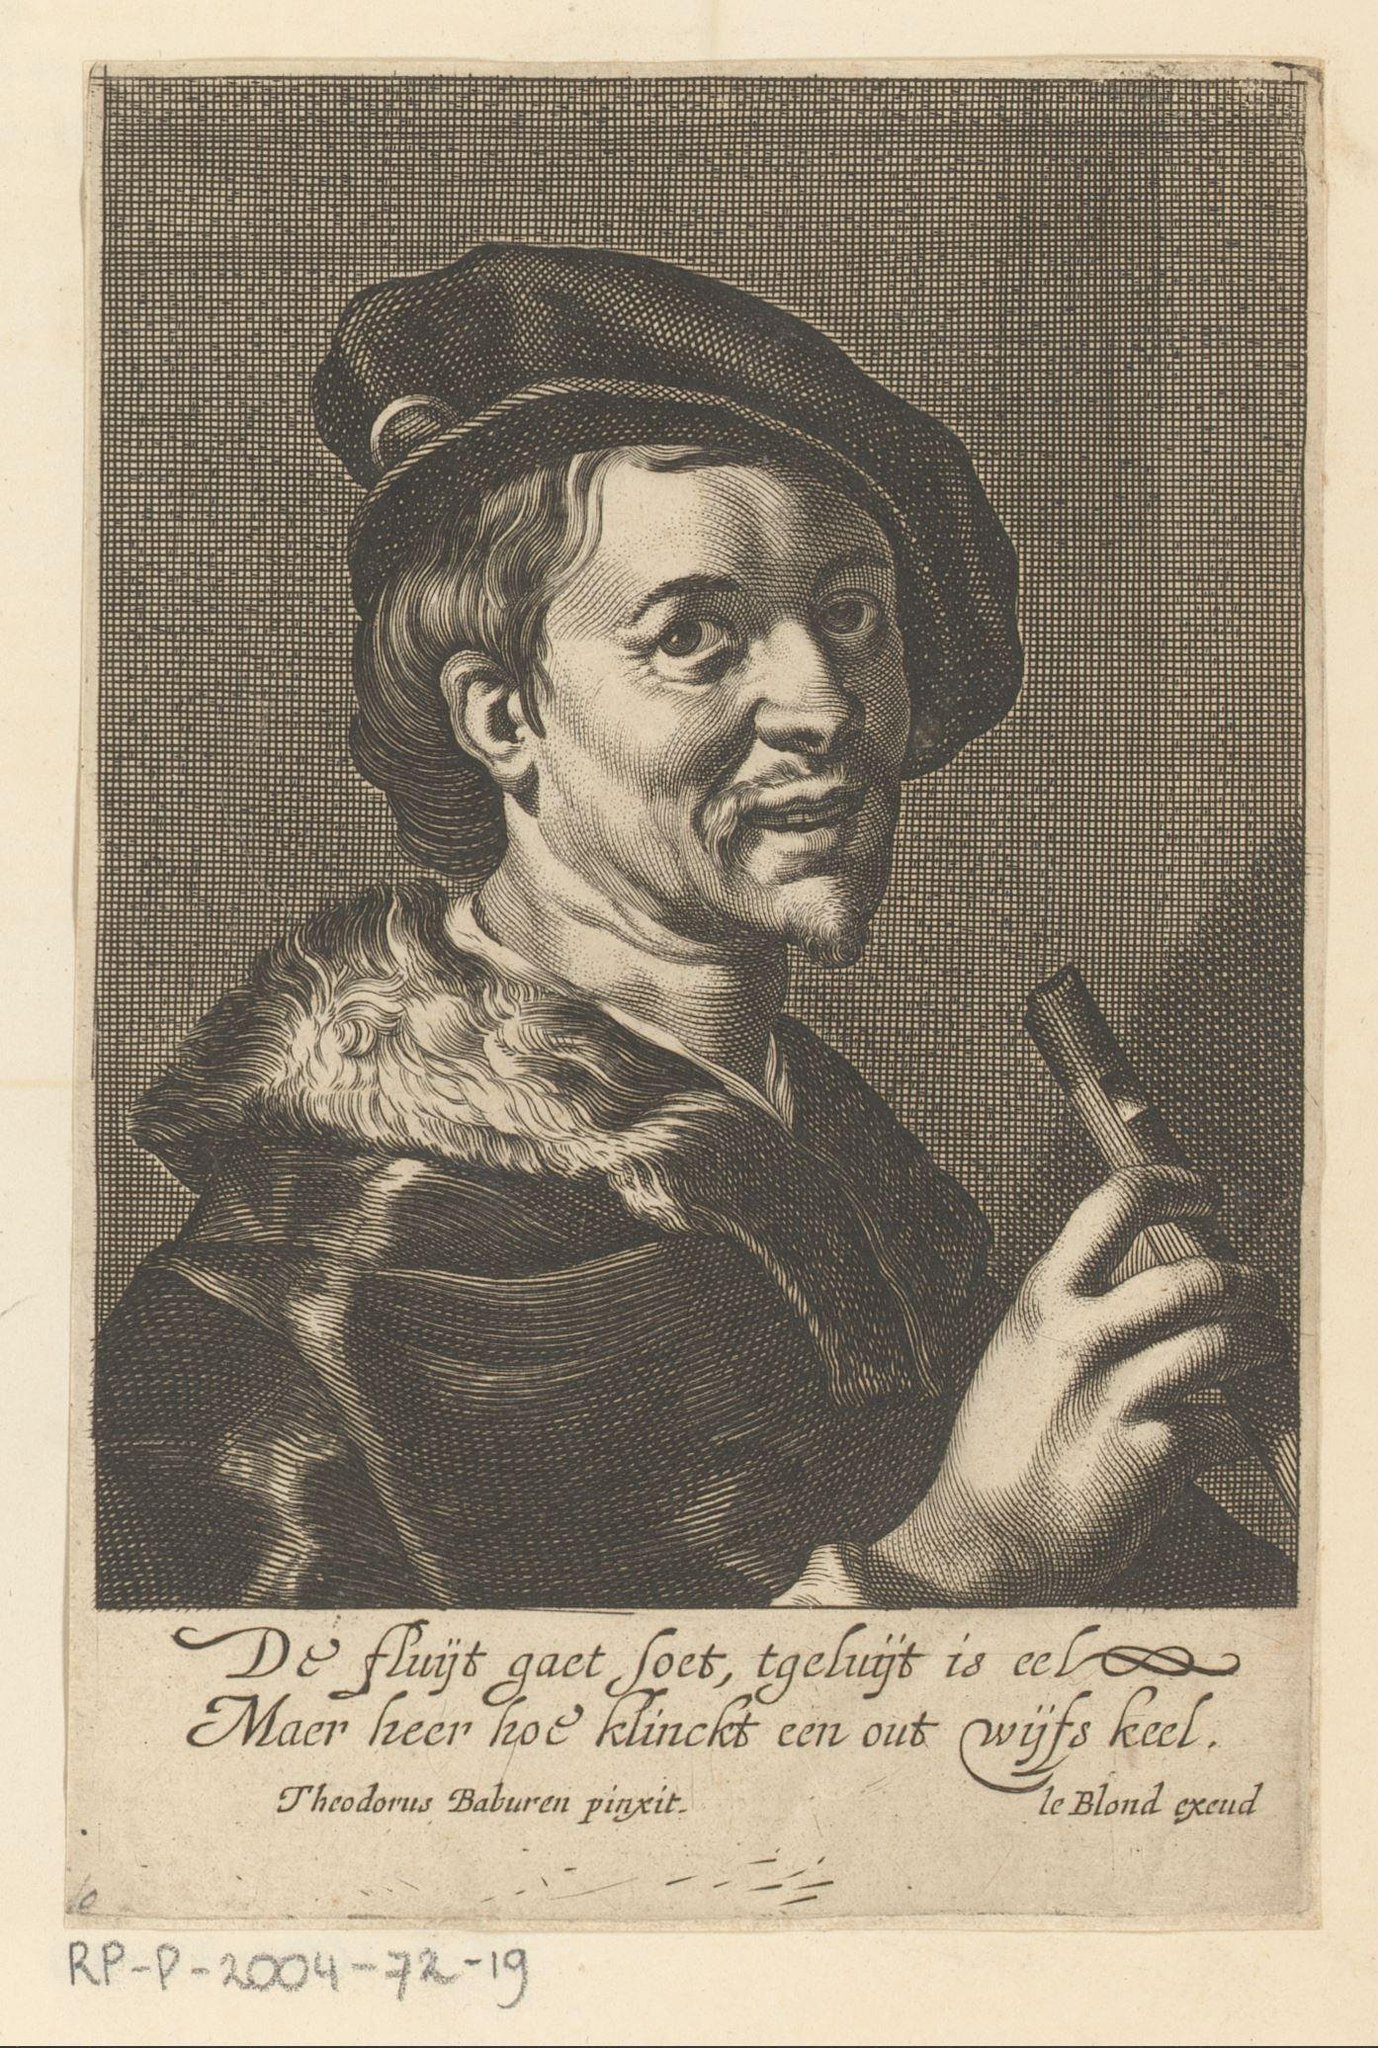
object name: print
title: Man met een fluit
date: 1625-1709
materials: paper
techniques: engraving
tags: adult man, flute, aulos, tibia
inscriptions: : ‘De fluijt gaet soet, tgeluijt is eel/ Maer heer hoe klinckt een out wijfs keel’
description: De samensteller heeft deze prent in het album geplakt als illustratie bij: Pilkington, Matthew en Johann Heinrich Füssli. A dictionary of painters, from the revival of the art to the present period. 4 dln. Londen: John Crowder, 1805, dl. 1, p. 20.